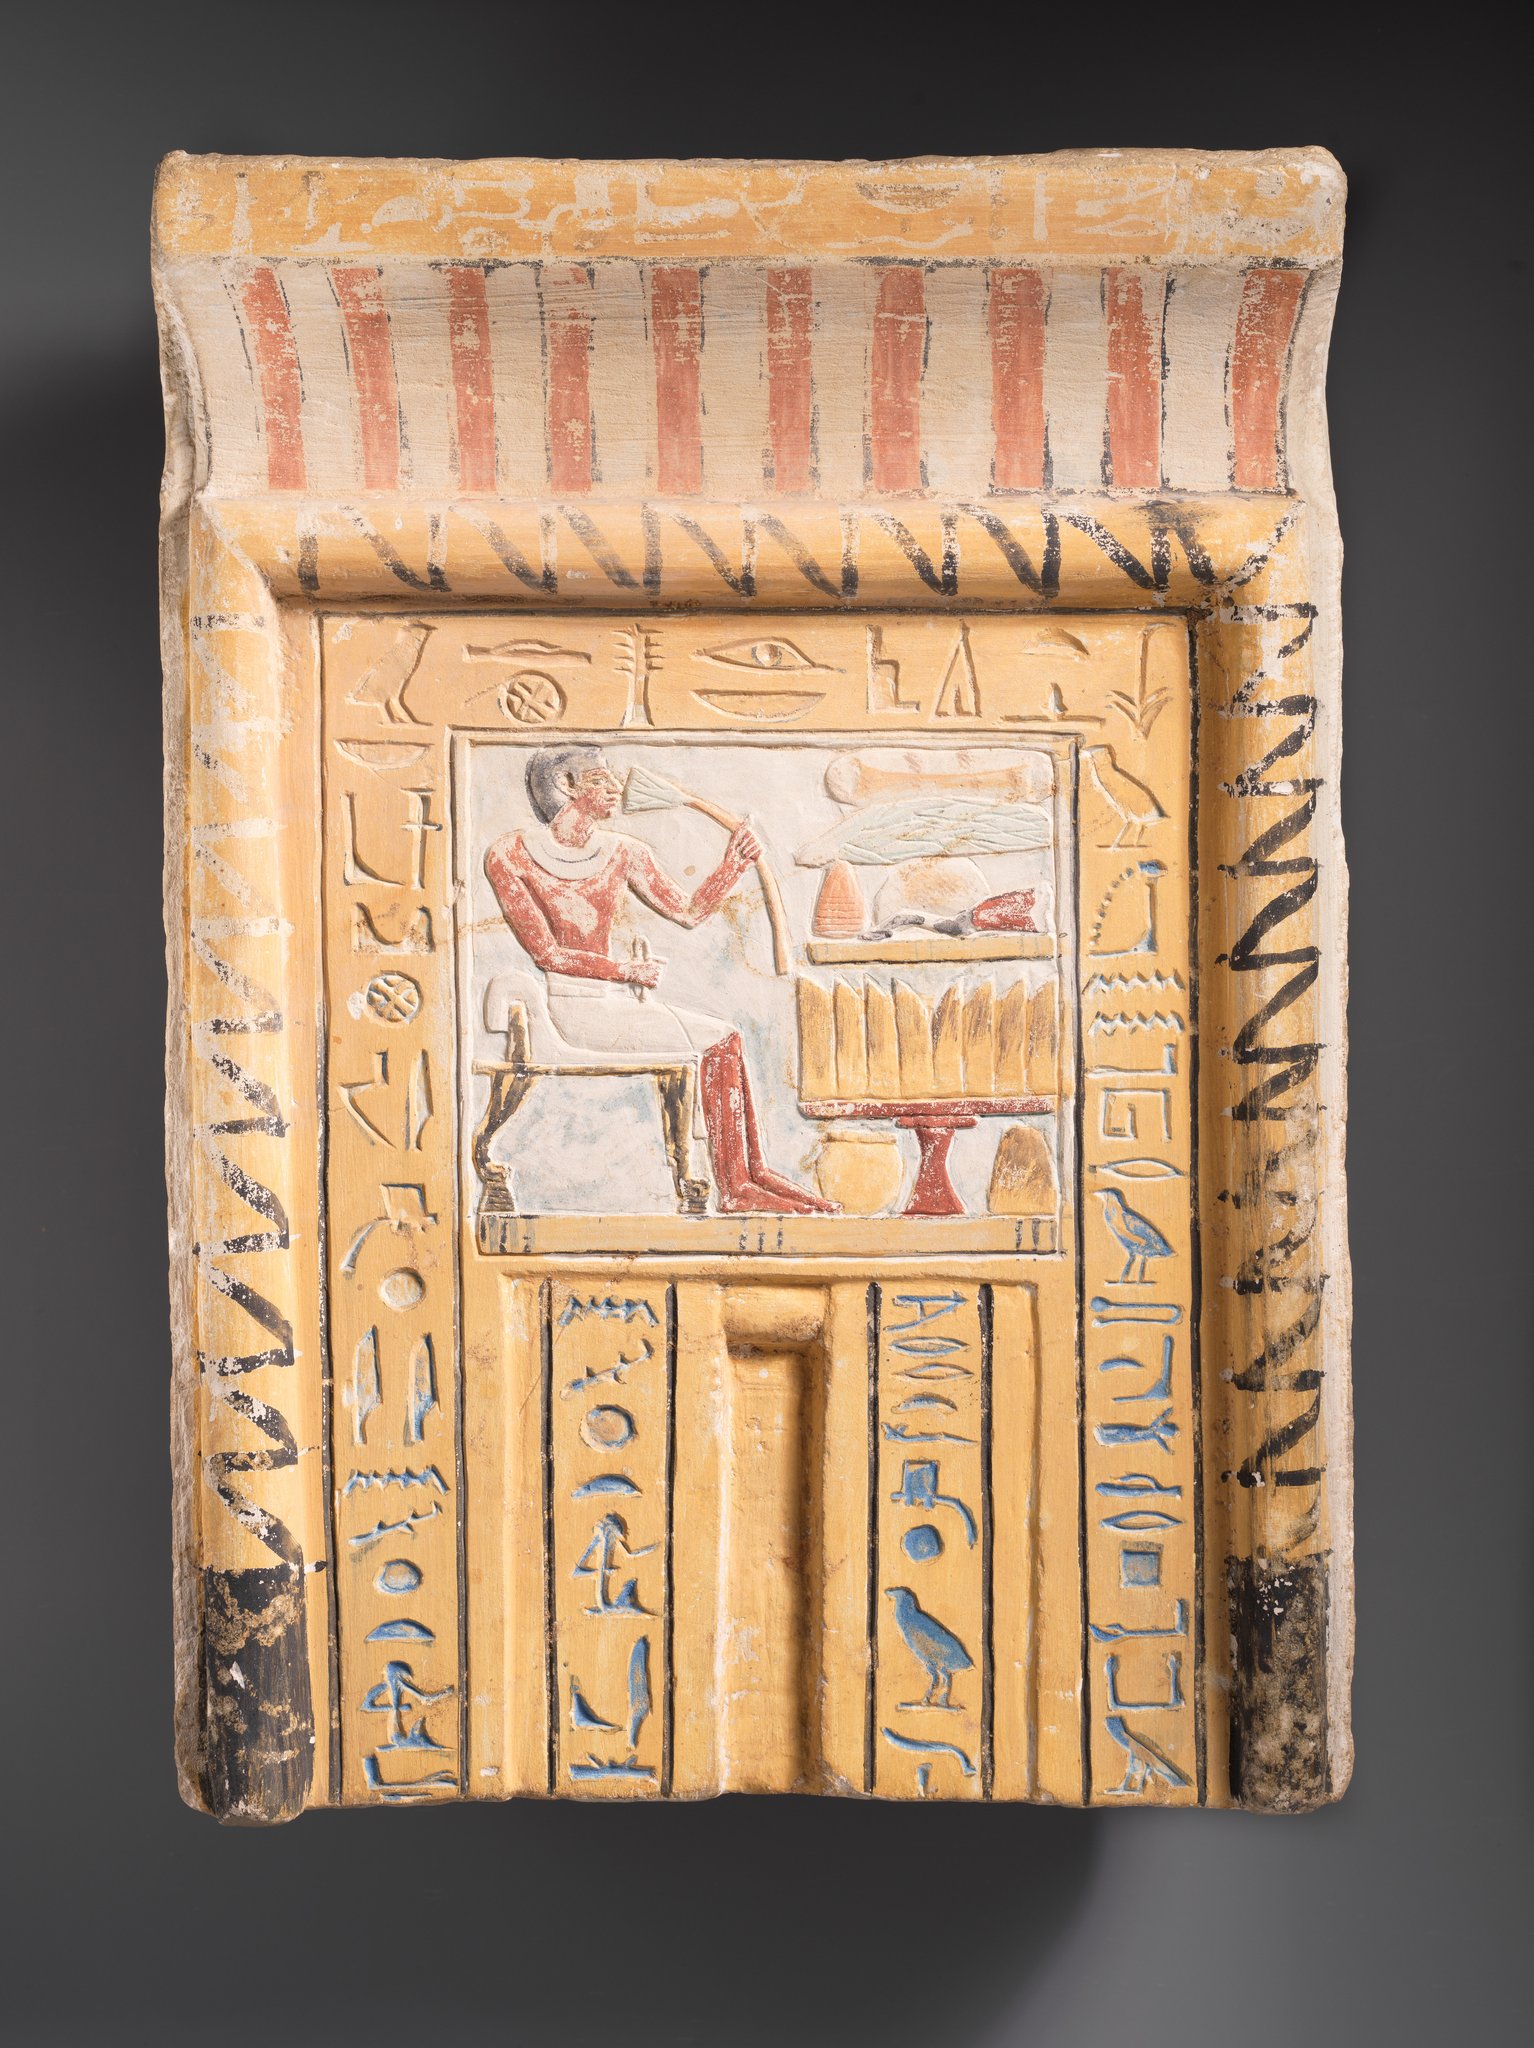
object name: stela, nakht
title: Stela of Nakht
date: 1950-1900 BCE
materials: limestone, paint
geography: upper egypt, thebes